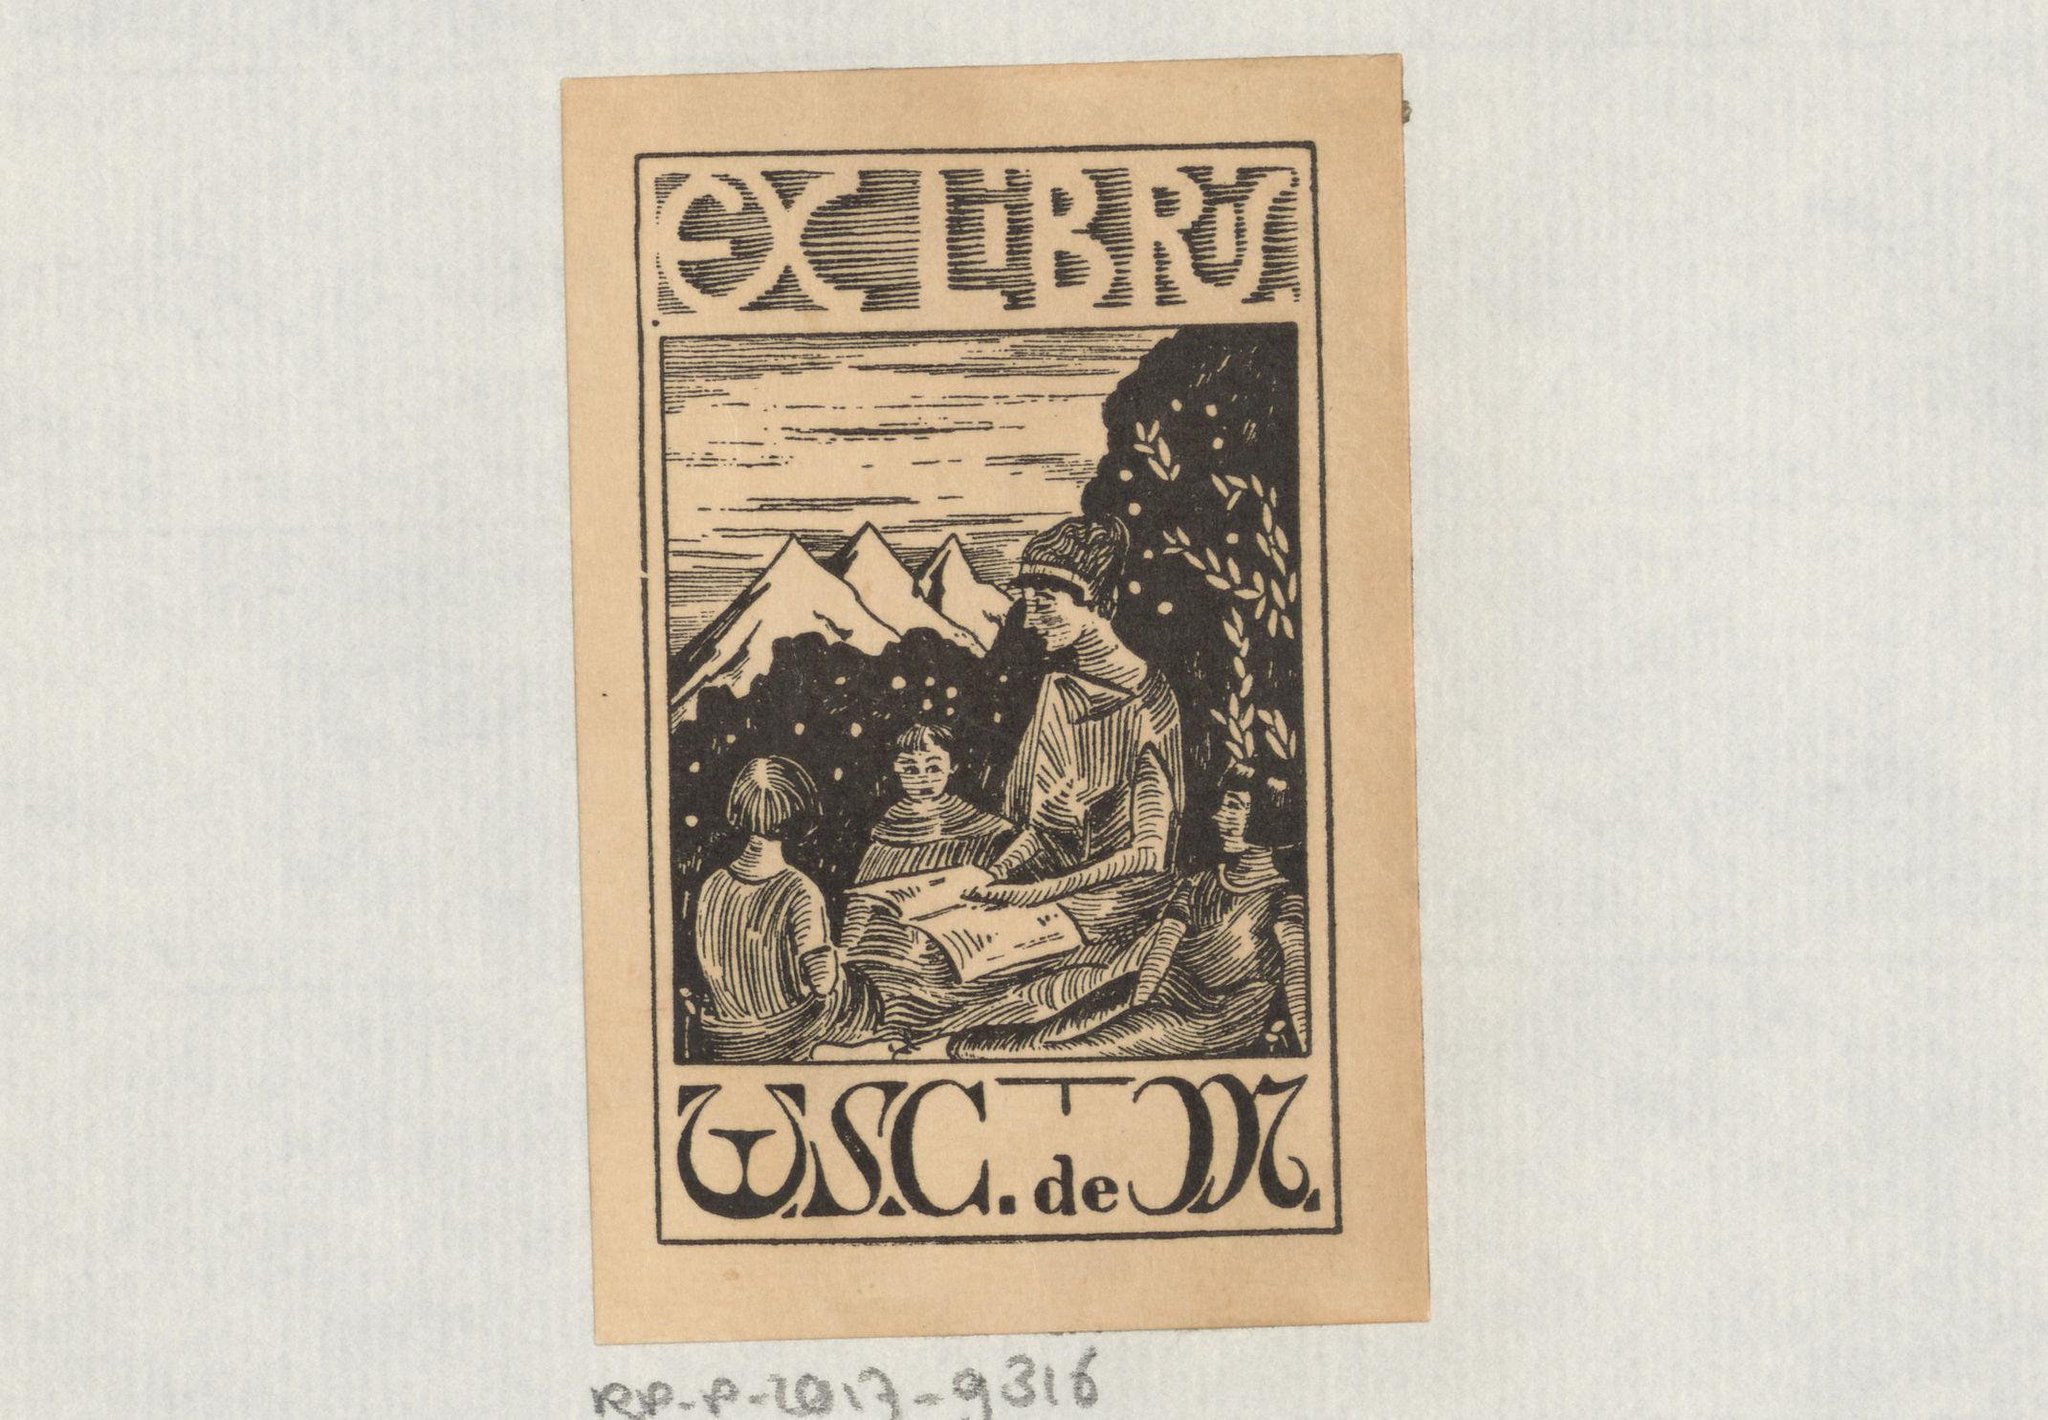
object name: bookplate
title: Ex libris van W.S.C. de. M.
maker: Anonymous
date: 1870-1949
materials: paper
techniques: printing block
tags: reading, landscapes, mother and child(ren), woman and child(ren) (family group)